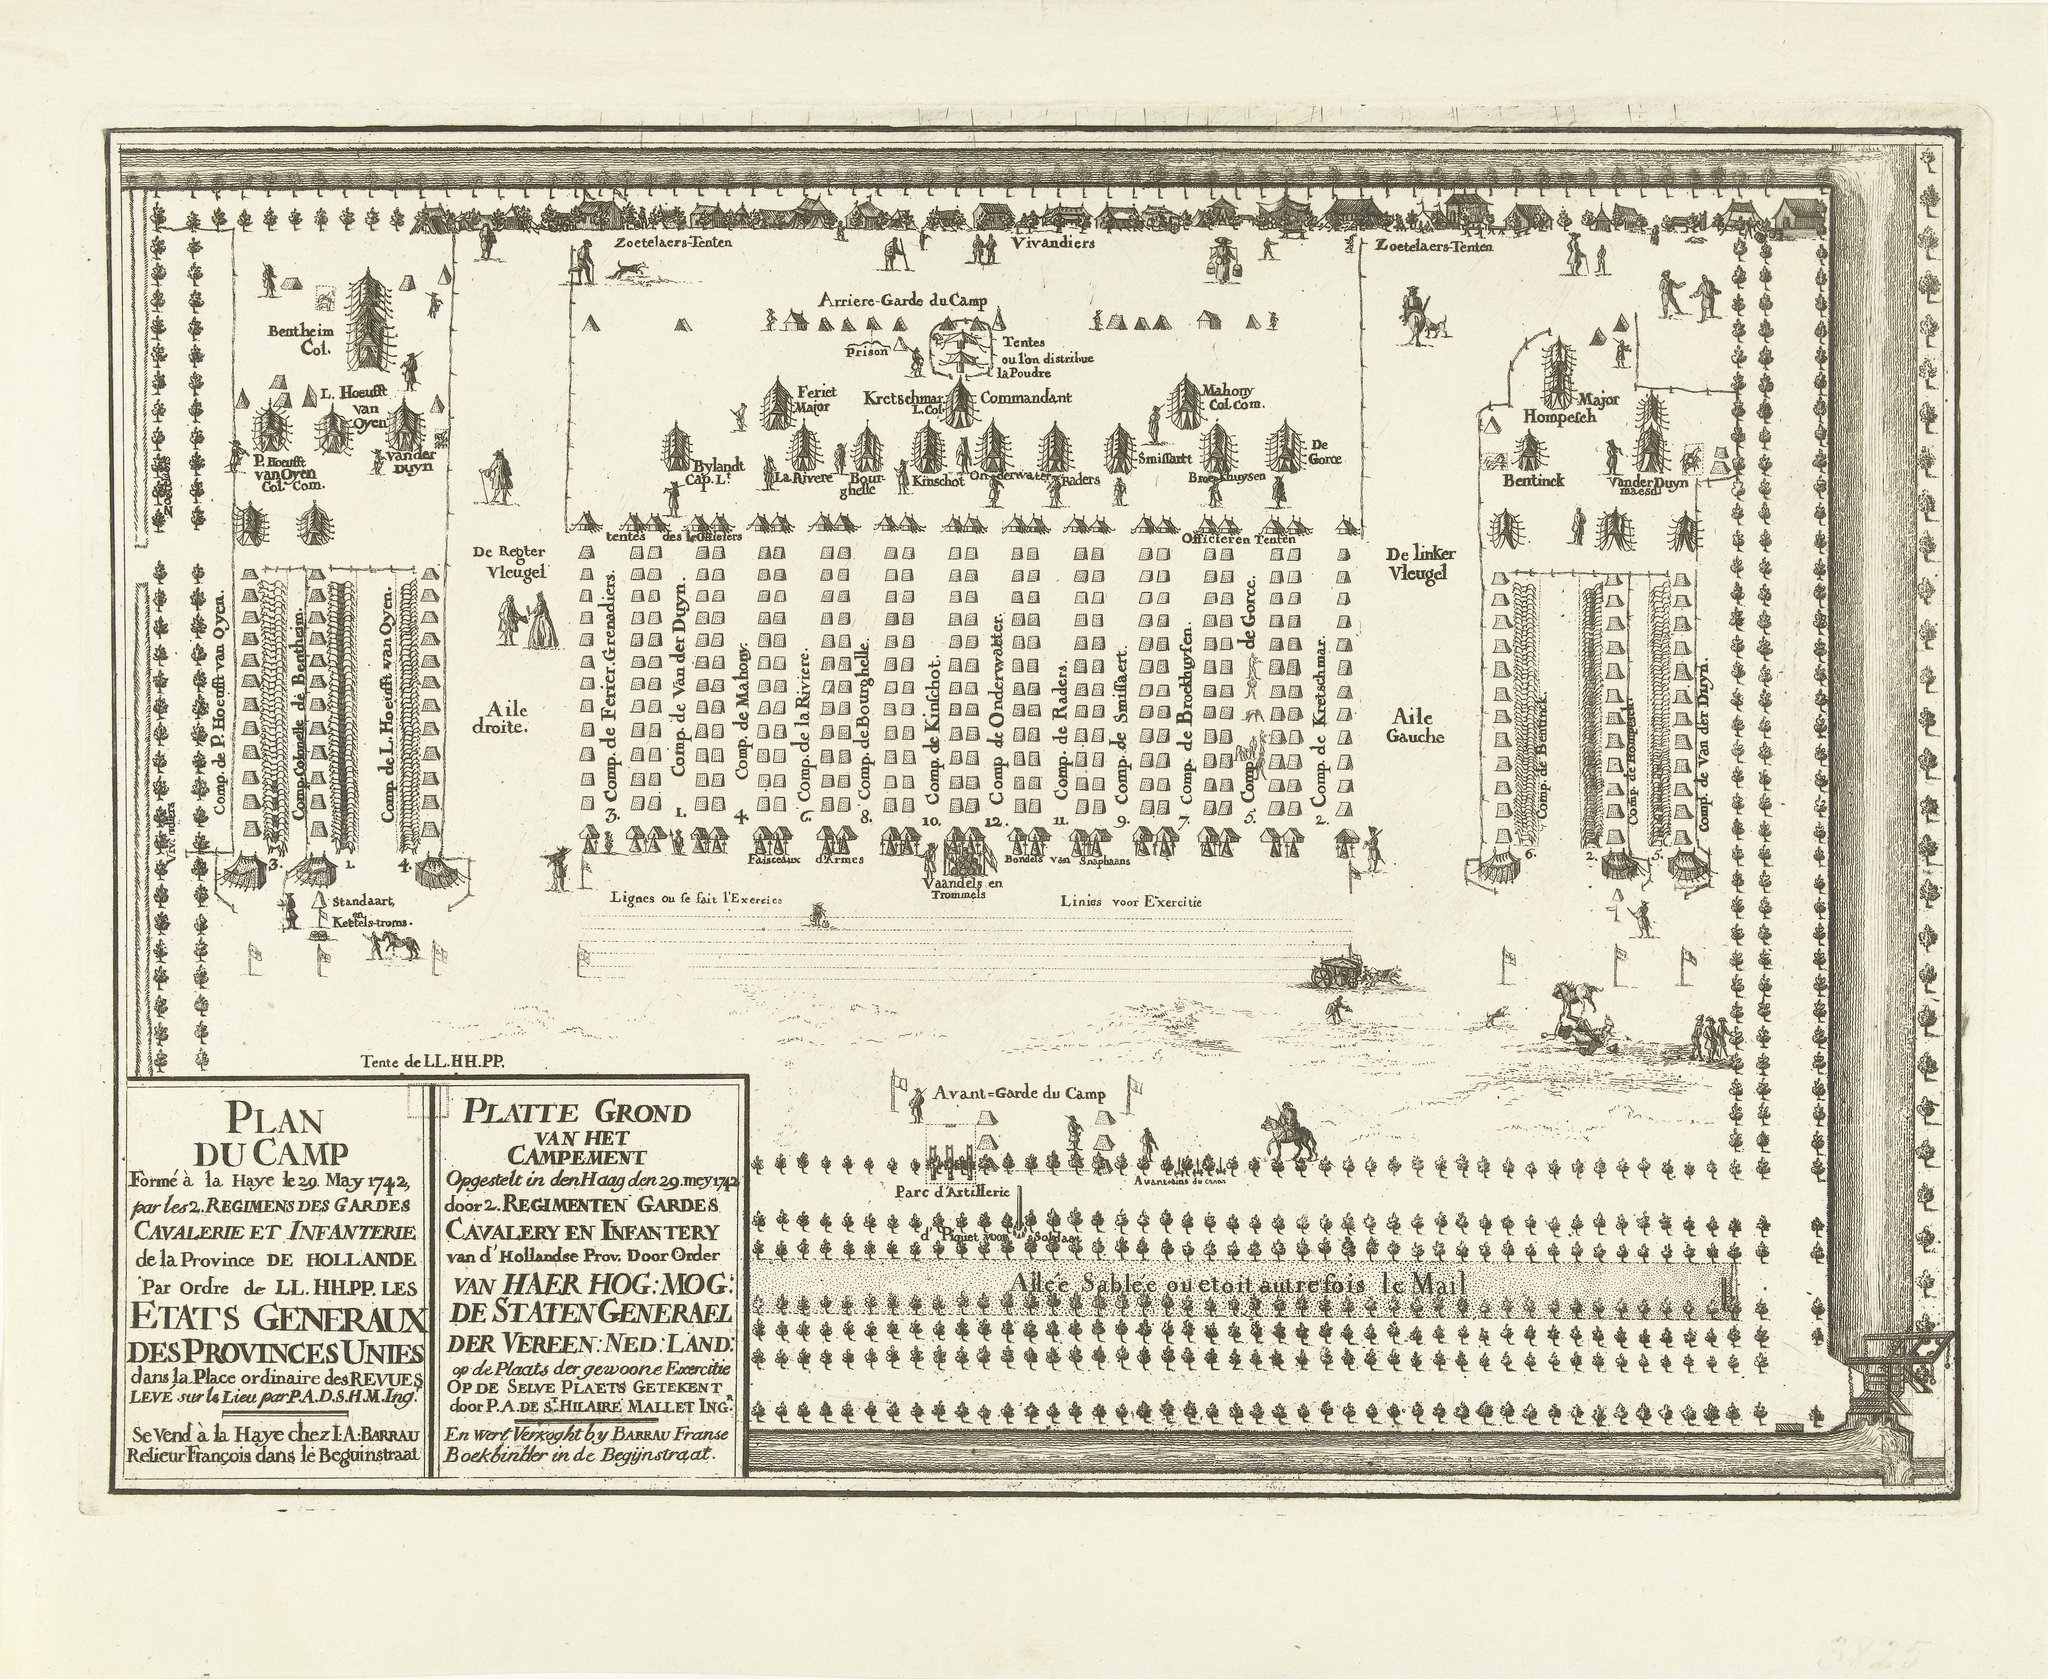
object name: print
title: Plan du Camp Formé à la Haye le 29. May 1742 (...) / Platte grond van het Campement Opgestelt in den Haag den 29. mey 1742 door 2. Regimenten Gardes Cavalery en Infantery van d'Hollandse Prov. Door Order van Haer Hog: Mog: de Staten Generael der vereen: Ned: Land: (...)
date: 1742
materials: paper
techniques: etching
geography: the hague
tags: (military) camp with tents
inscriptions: collector's mark: Lugt 2228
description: Plattegrond van de grote legeroefening het Kampement te Den Haag, een legerkamp opgeslagen op bevel van de Staten van Holland en West-Friesland in het Haagse Bos bij Den Haag, 29 mei 1742.